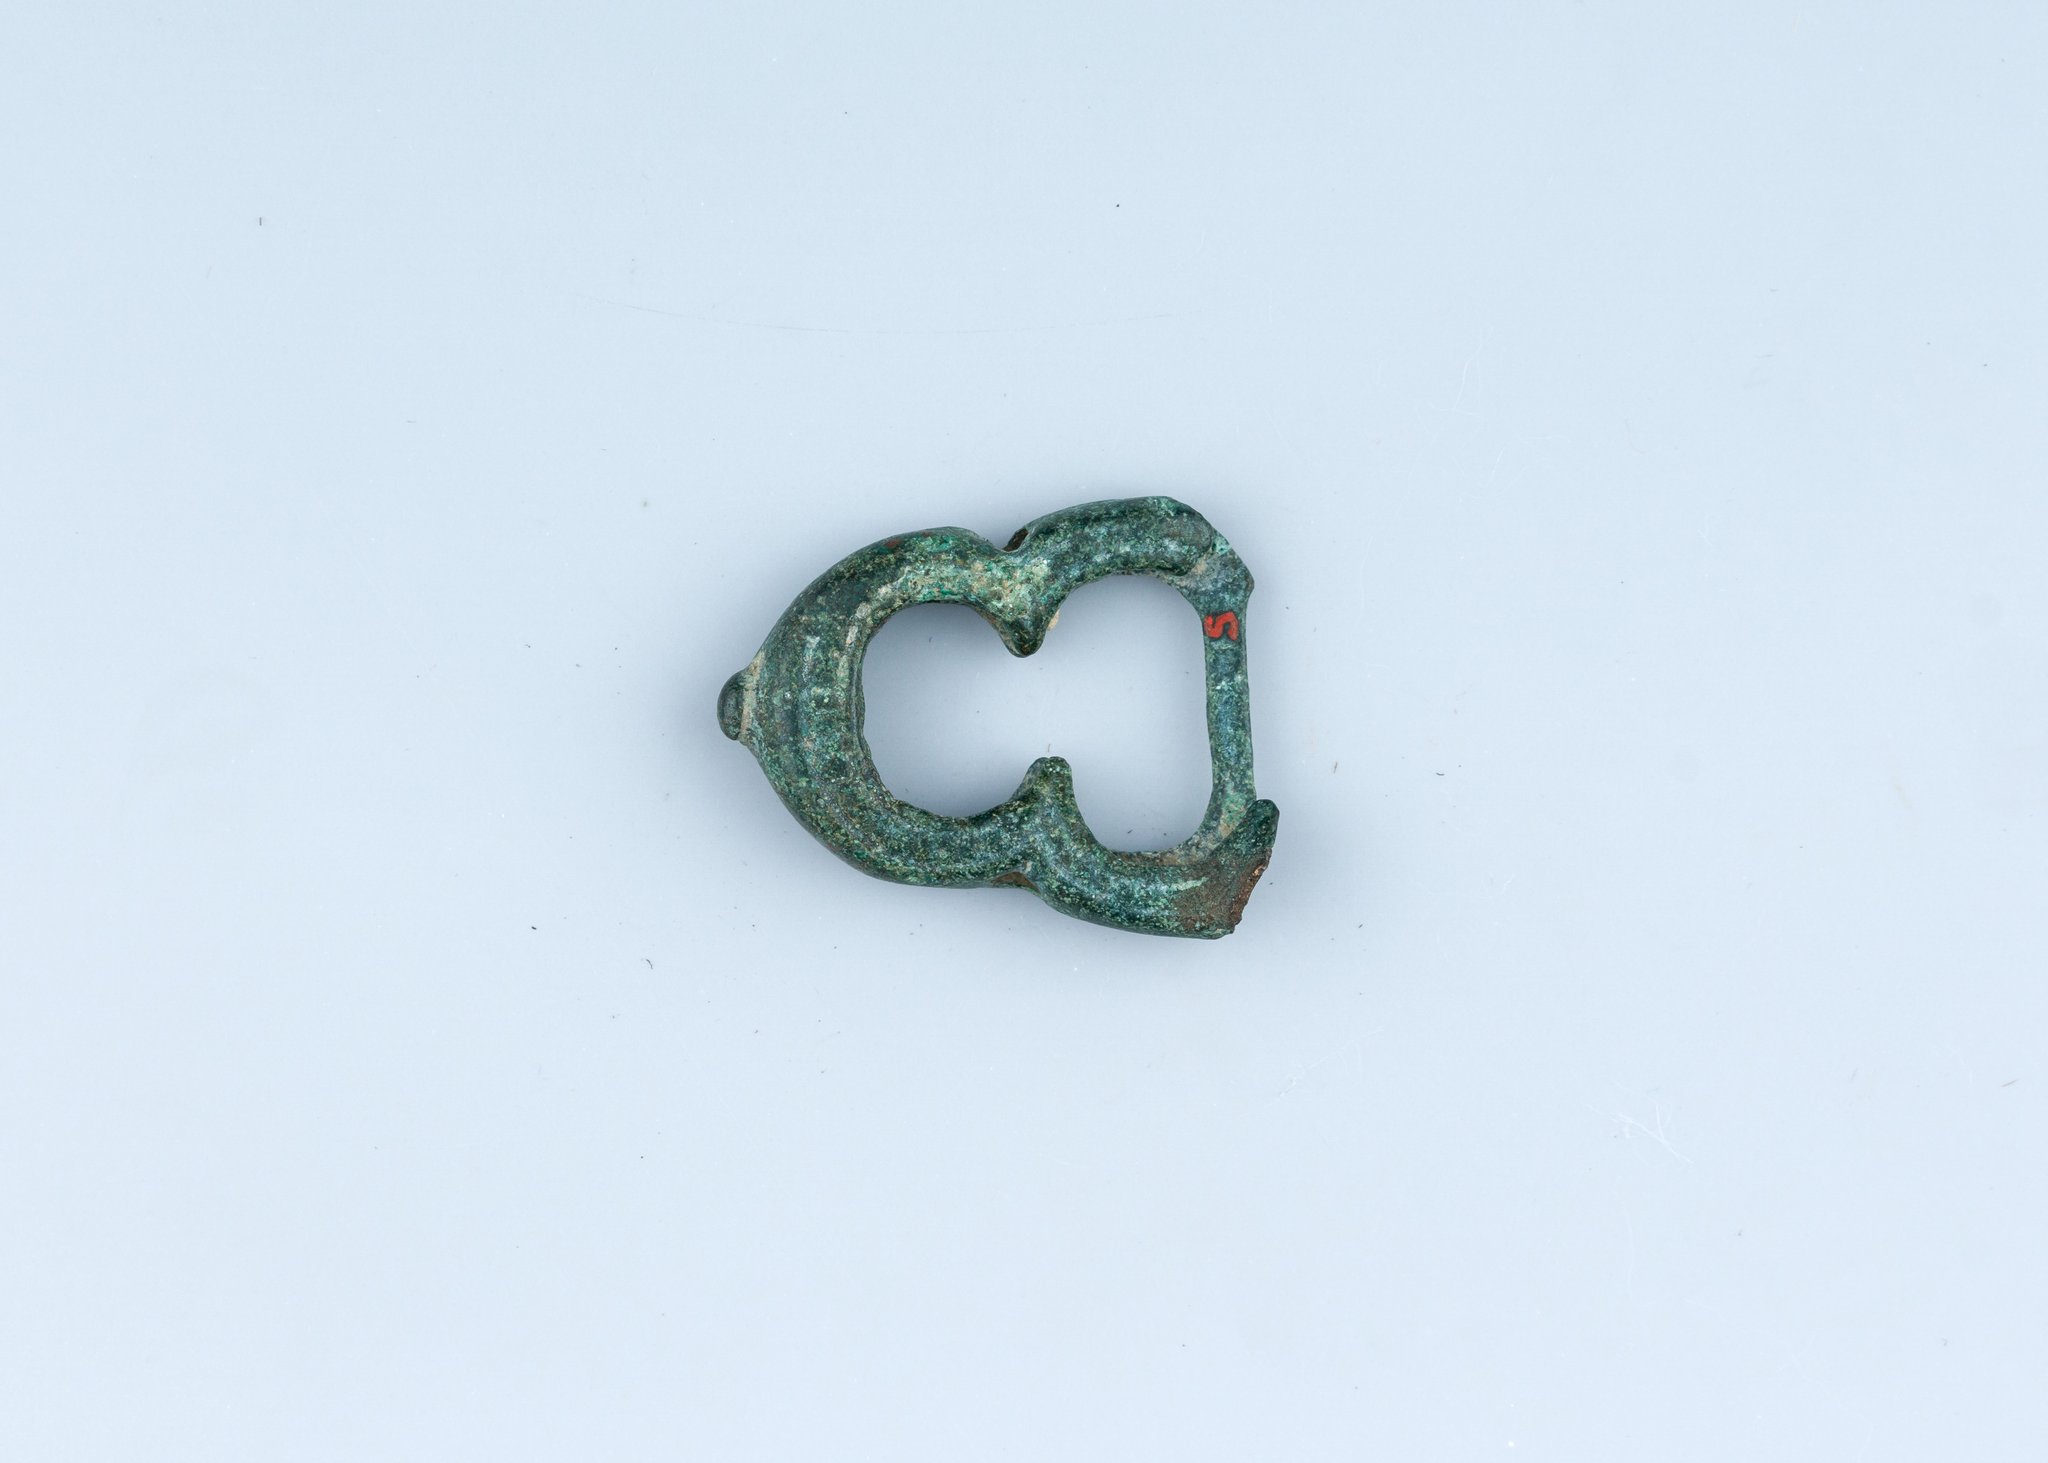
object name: mordant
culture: european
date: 1401-1700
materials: bronze, patina